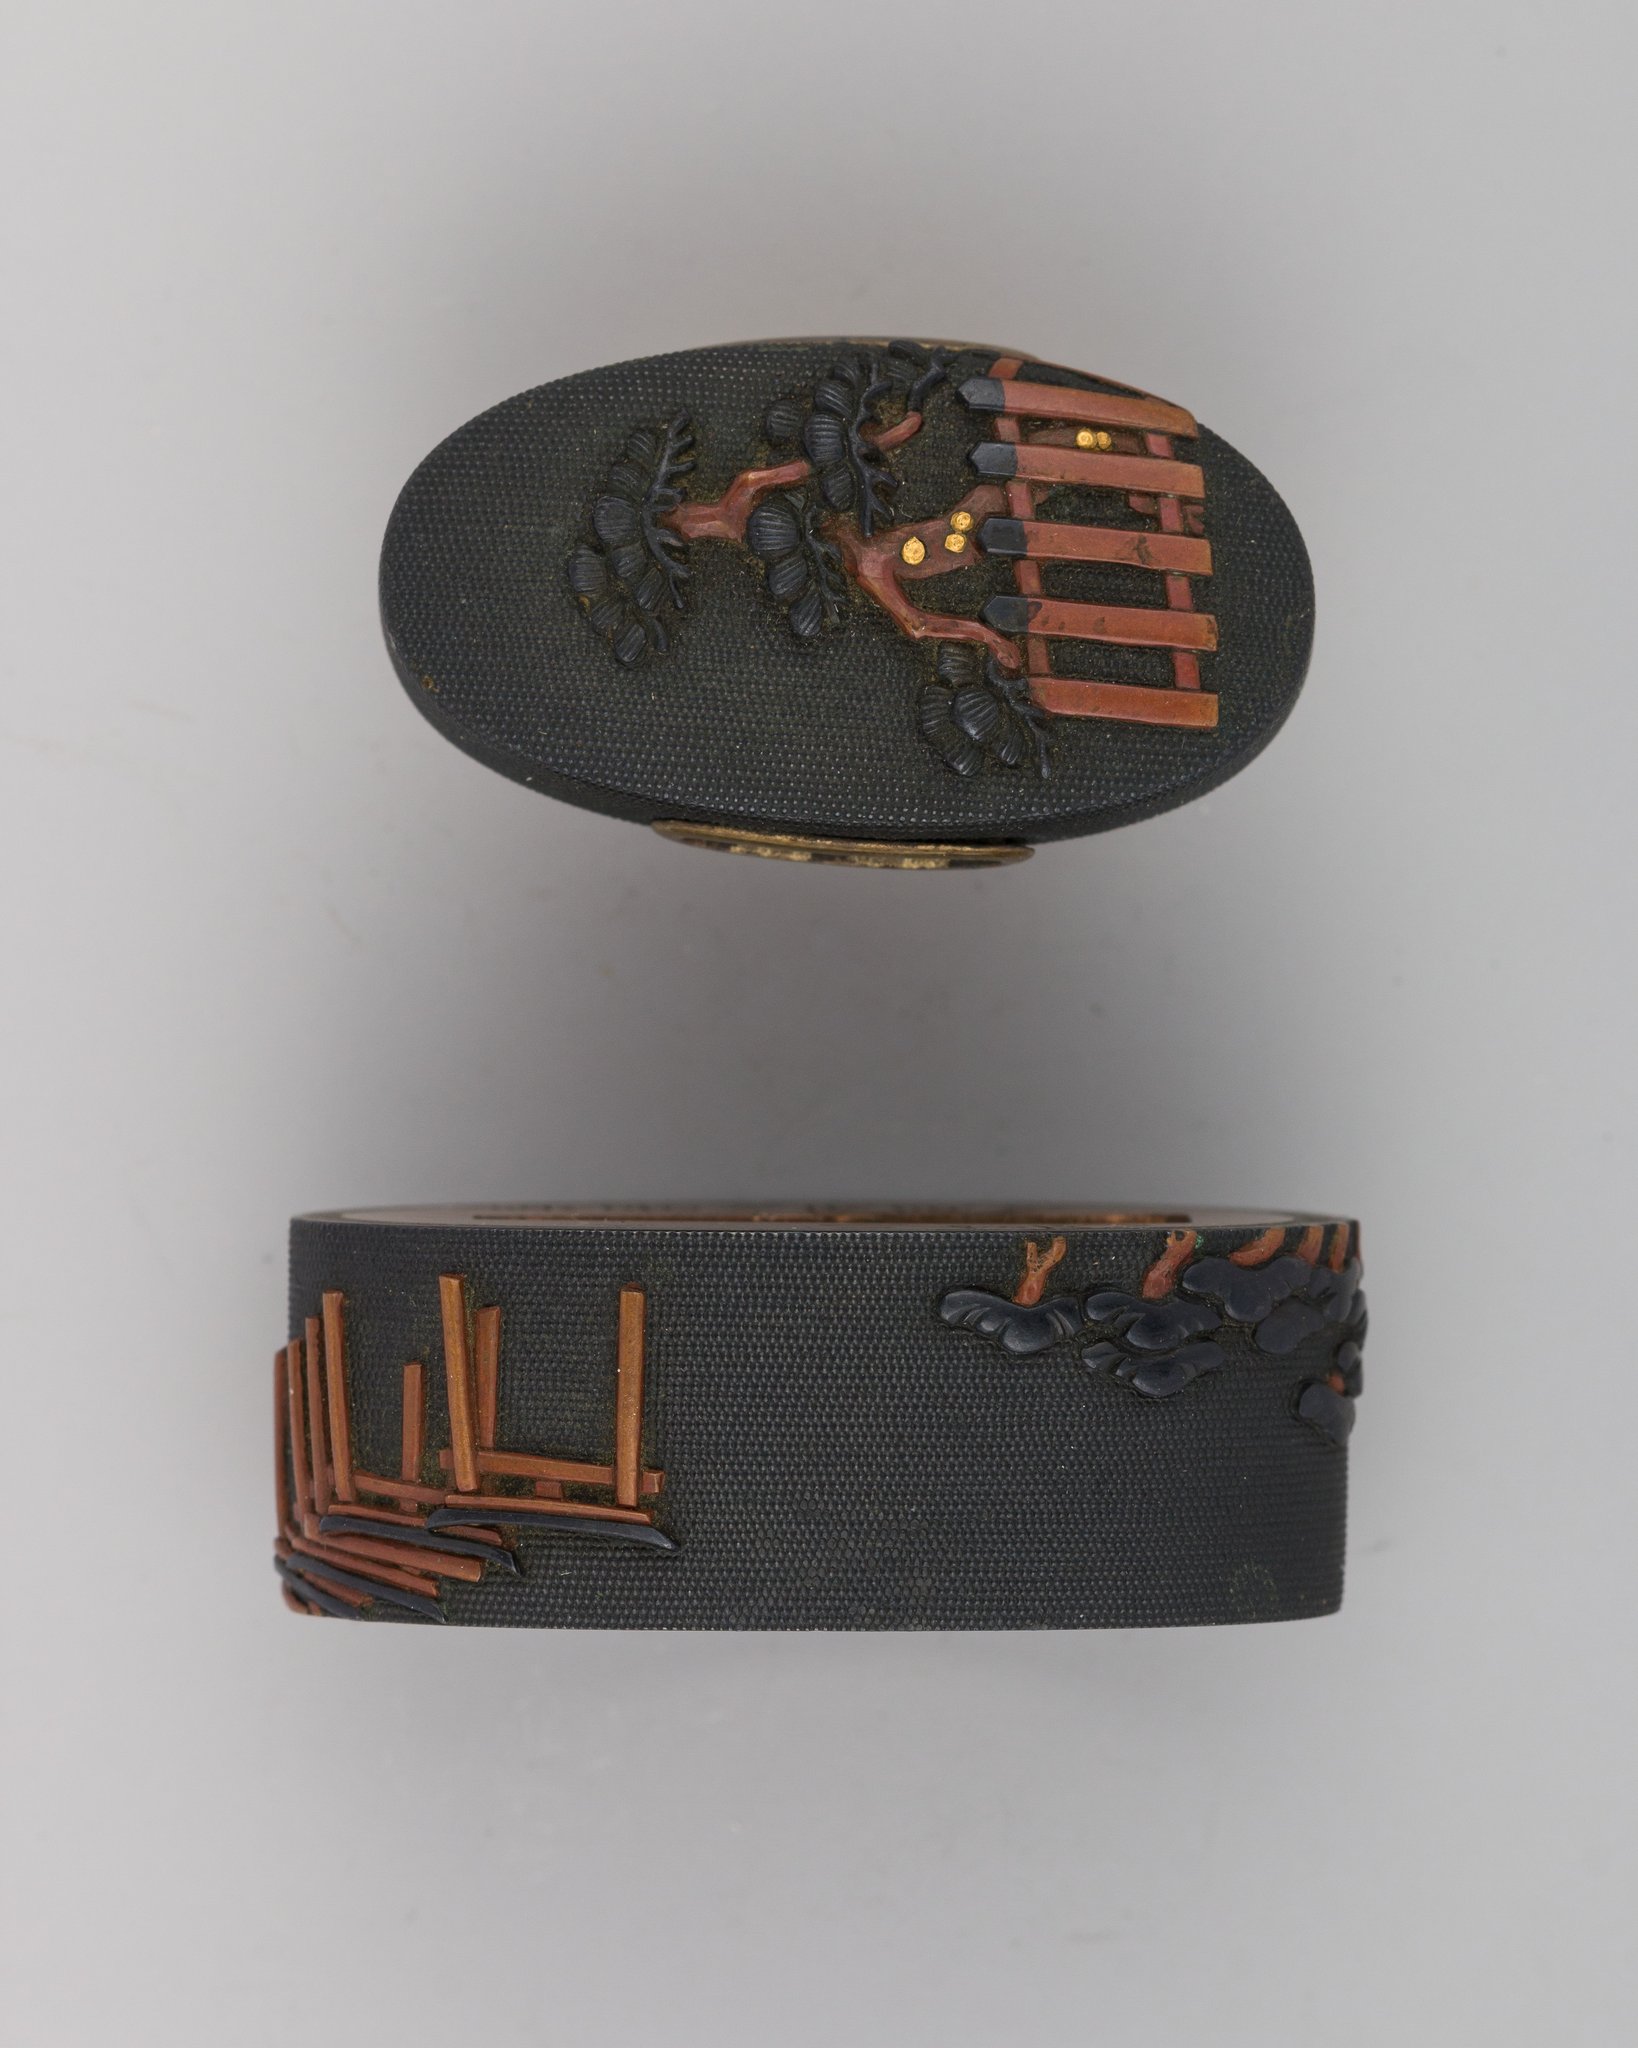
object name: sword hilt collar and pommel fuchigashira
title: Sword-Hilt Collar and Pommel (Fuchigashira)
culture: japanese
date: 1801-1900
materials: copper, gold alloy, gold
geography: japan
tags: fences,trees